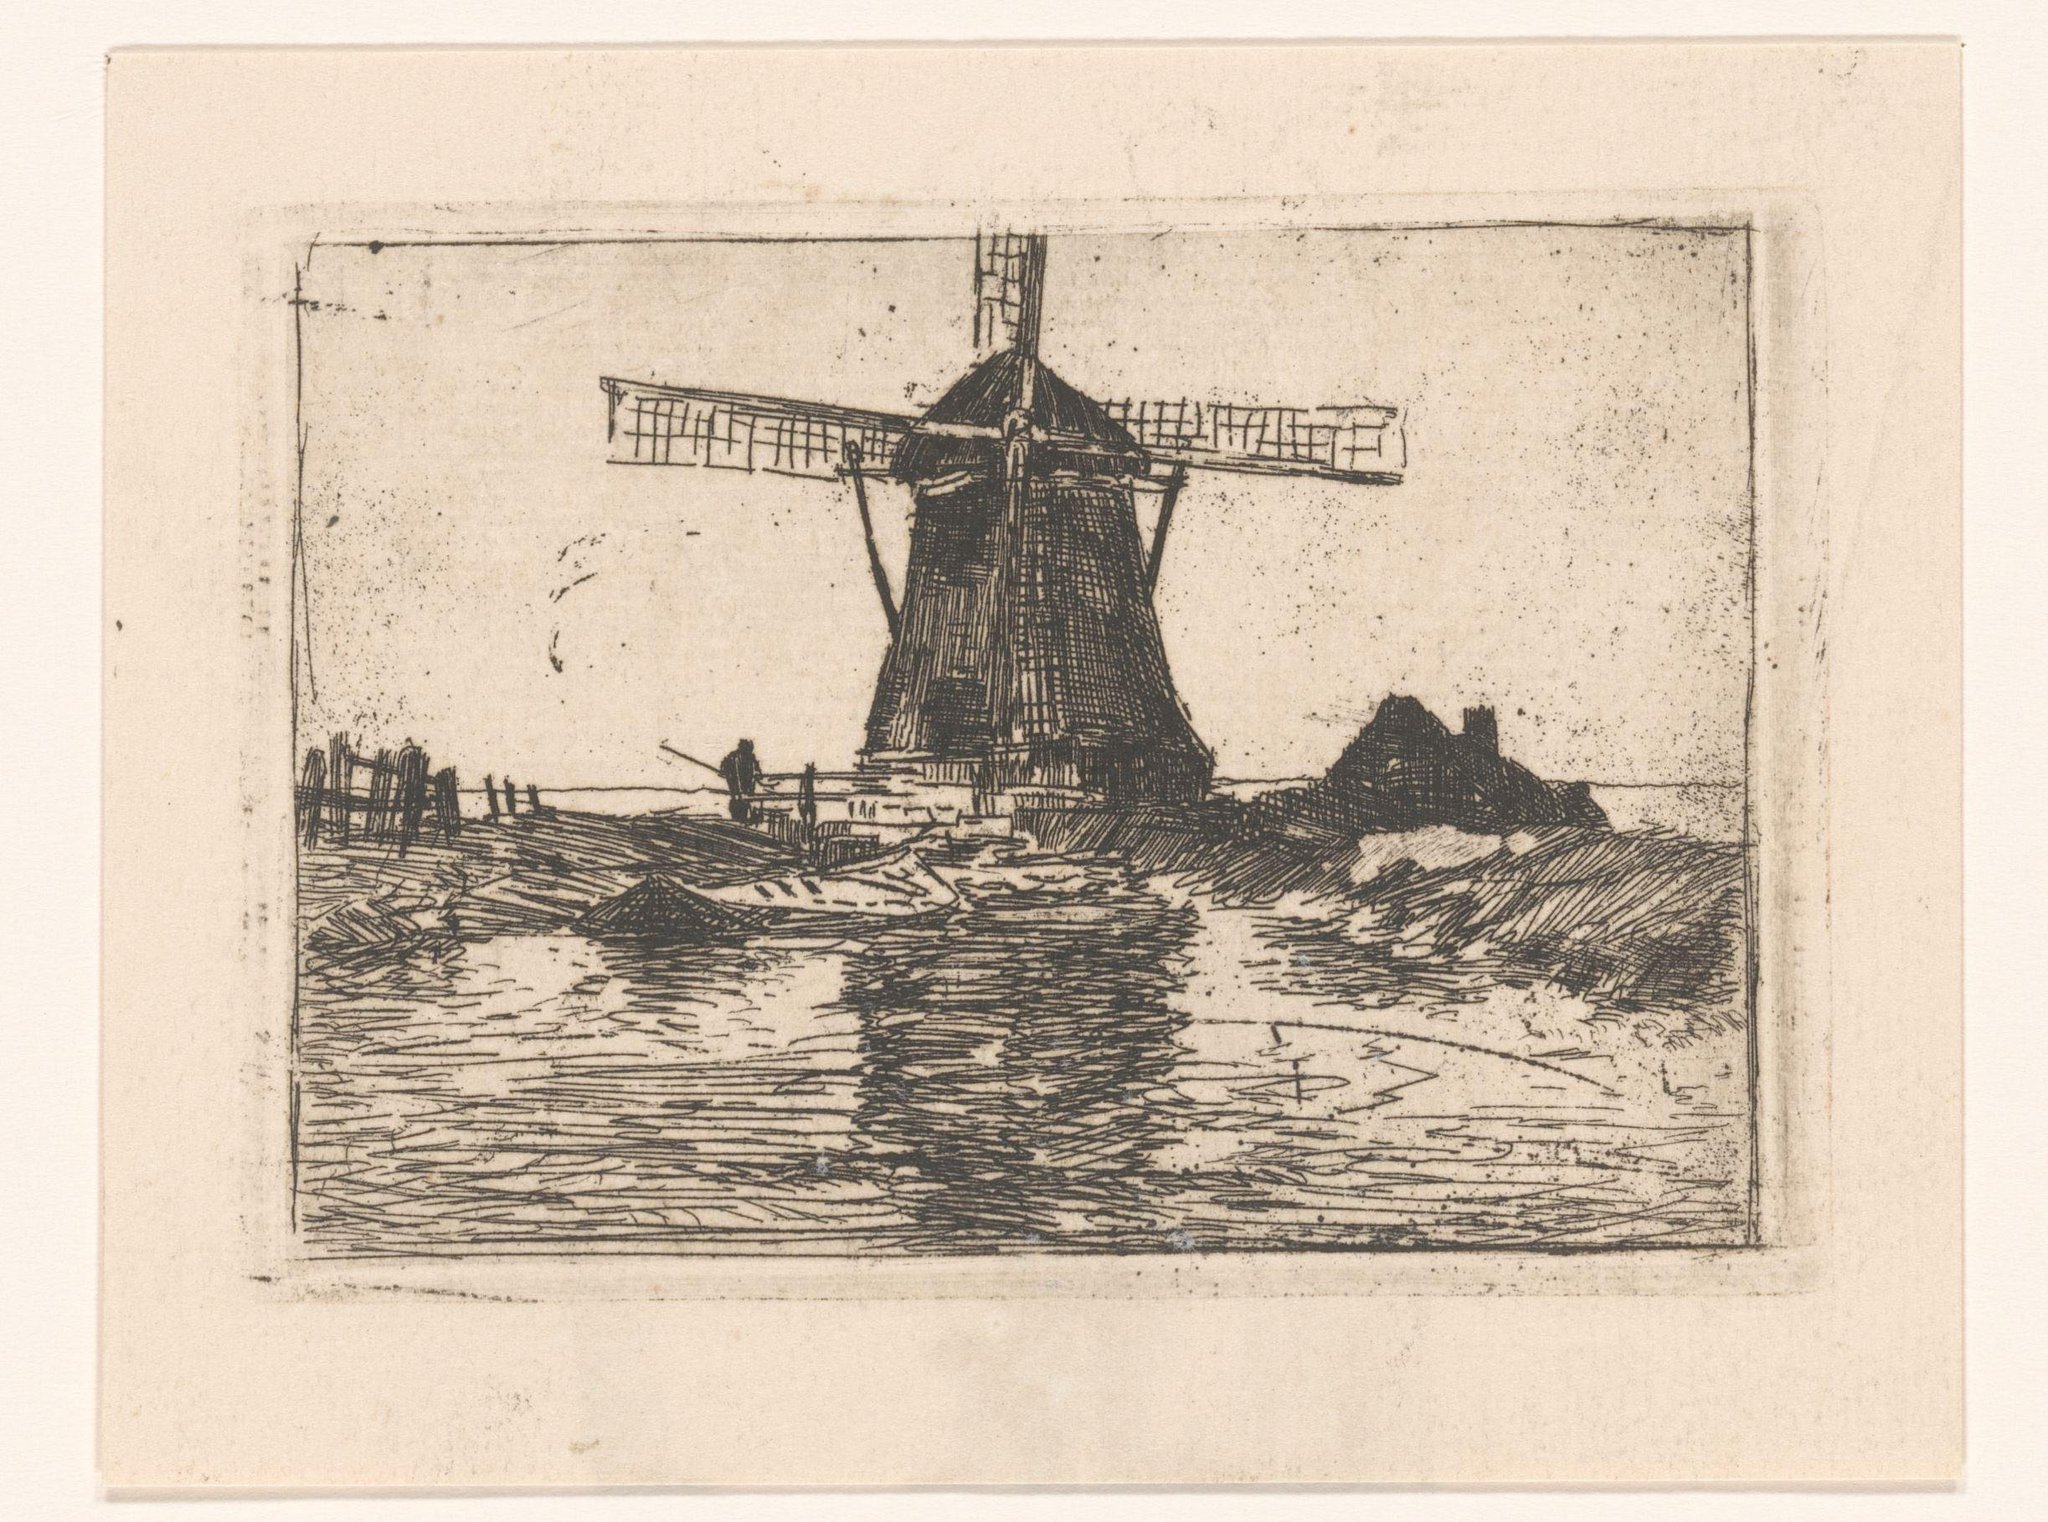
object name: print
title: Molen bij een vaart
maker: chris van der windt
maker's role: print maker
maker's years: 1877-1952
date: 1887-1952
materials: paper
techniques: etching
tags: windmill in landscape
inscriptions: collector's mark: Lugt 2228